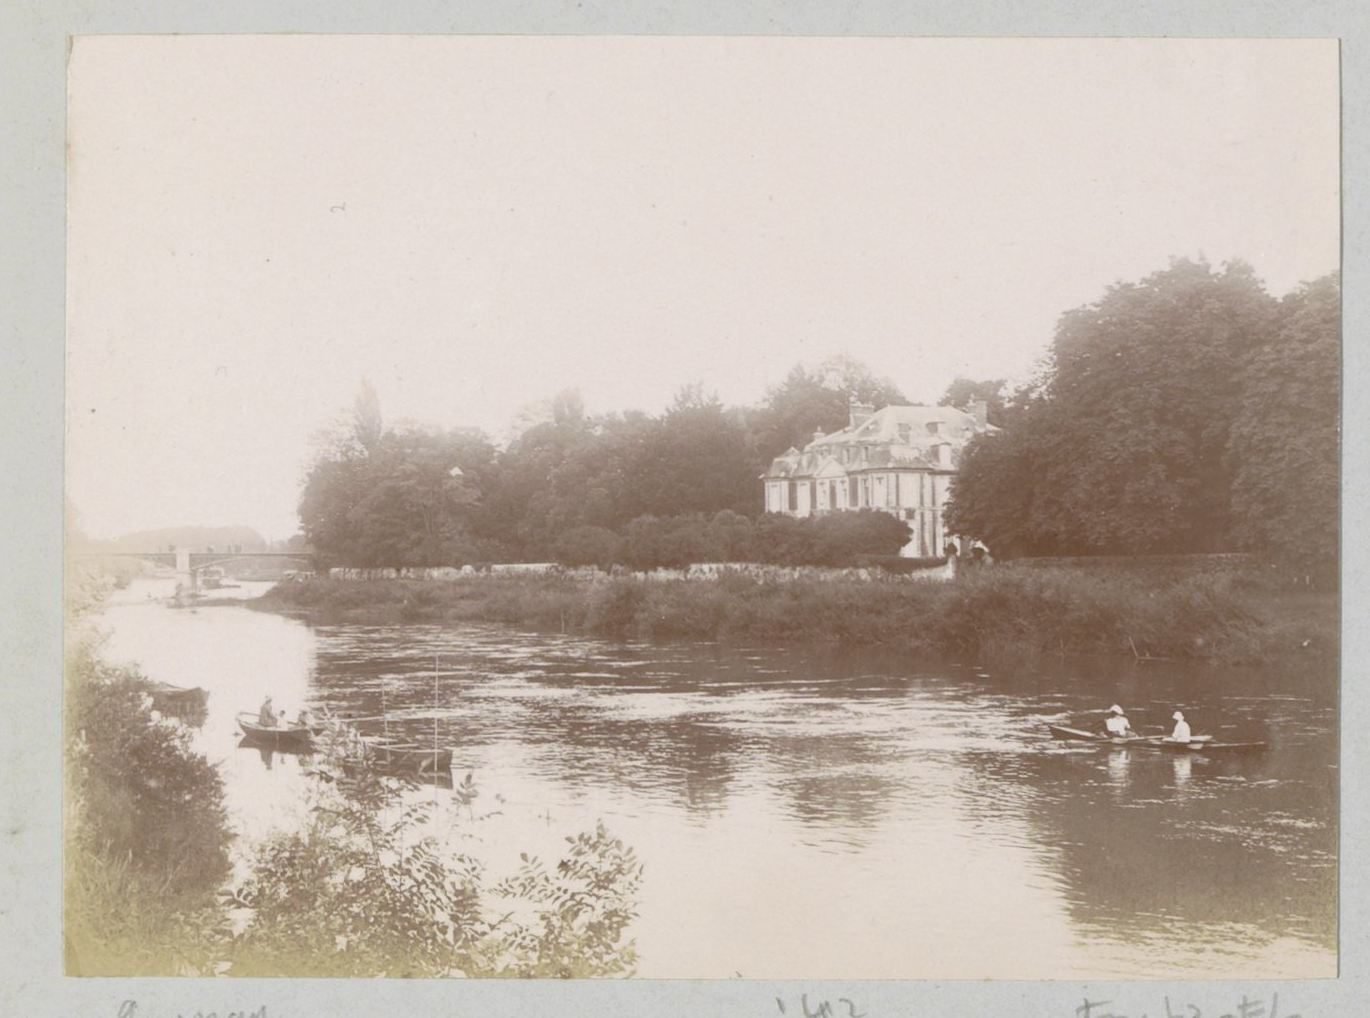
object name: photograph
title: Gezicht op de rivier bij Gournay-sur-Marne met landhuis, brug en roeiboten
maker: delizy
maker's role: manufacturer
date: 1897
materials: paper, photographic support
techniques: gelatin silver print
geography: gournay-sur-marne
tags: rural housing, e.g. country-house, villa, cottage, rowing-boat, canoe, etc., river (+ landscape with figures, staffage)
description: Onderdeel van Fotoalbum van een Franse amateurfotograaf met opnames van uitstapjes in Frankrijk, Spanje, België, Luxemburg en Nederland, de eerste automobielen en autoraces.